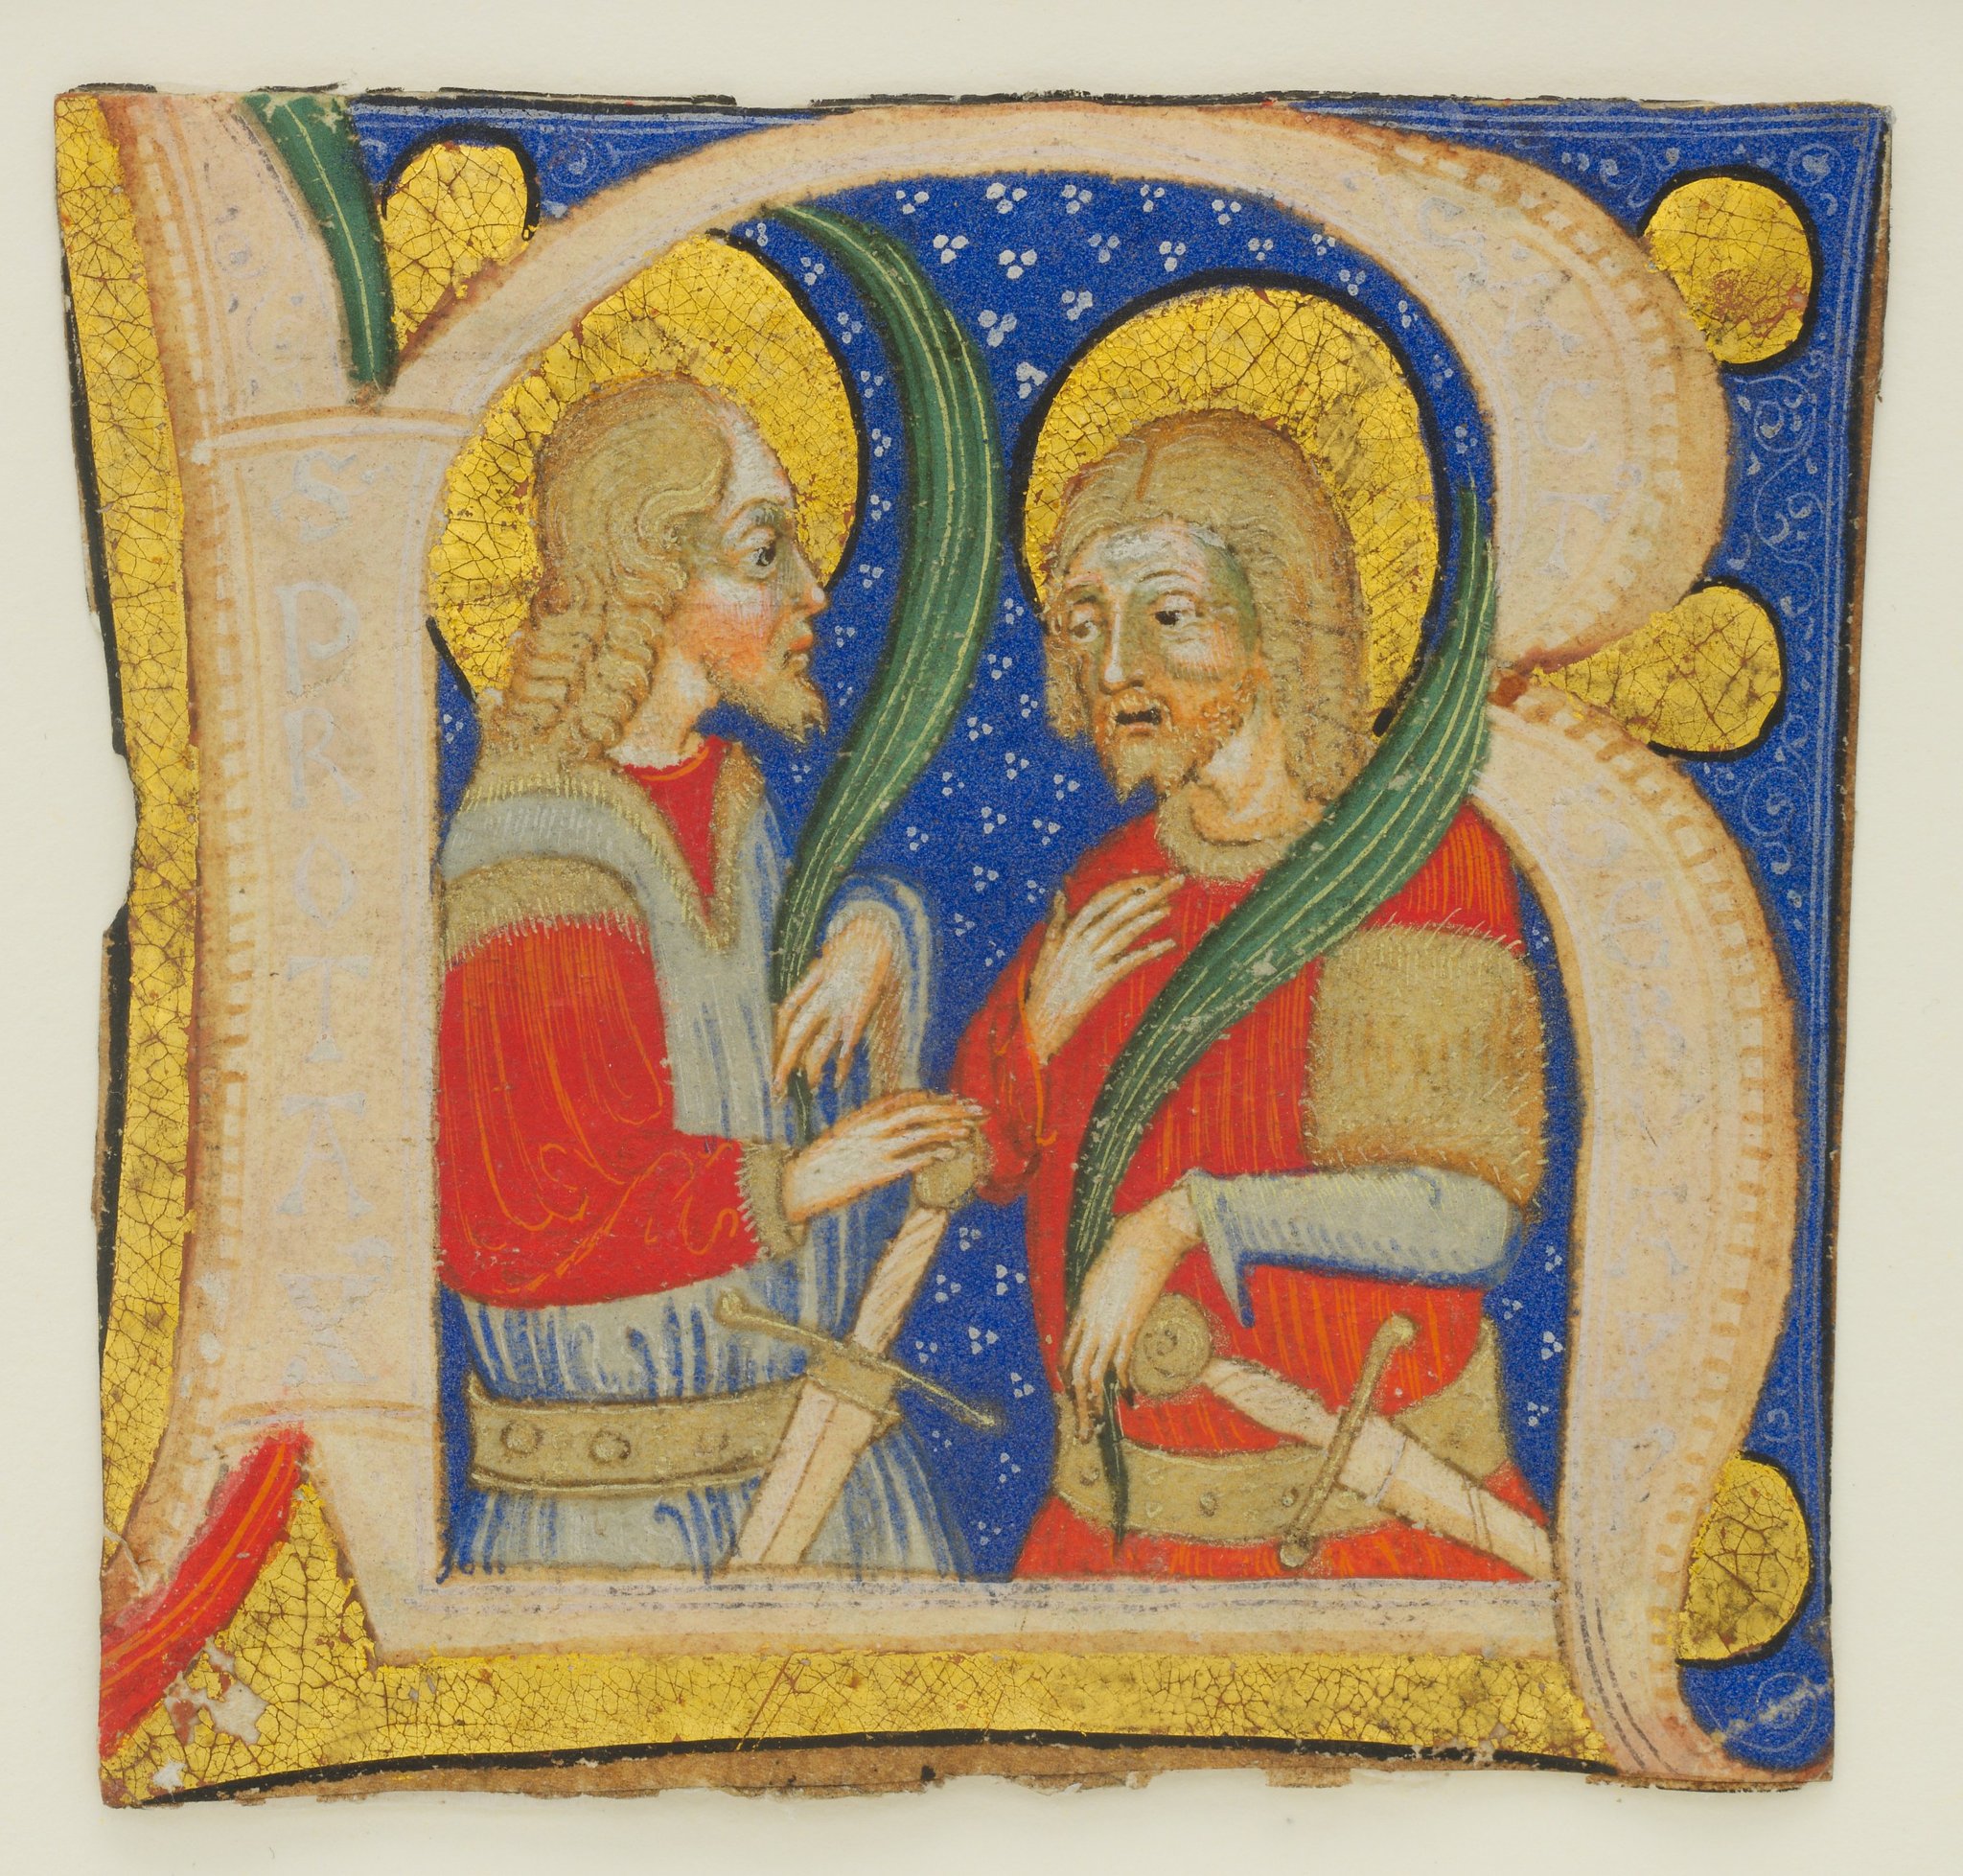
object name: manuscript leaf cutting from a breviary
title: Manuscript Leaf Cutting showing an Illuminated Initial R with St. Protasius and St. Gervasius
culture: italian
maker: olivetan master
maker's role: artist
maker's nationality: lombard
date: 1434-1466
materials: gold, ink, parchment, paint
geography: italy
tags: men,saints